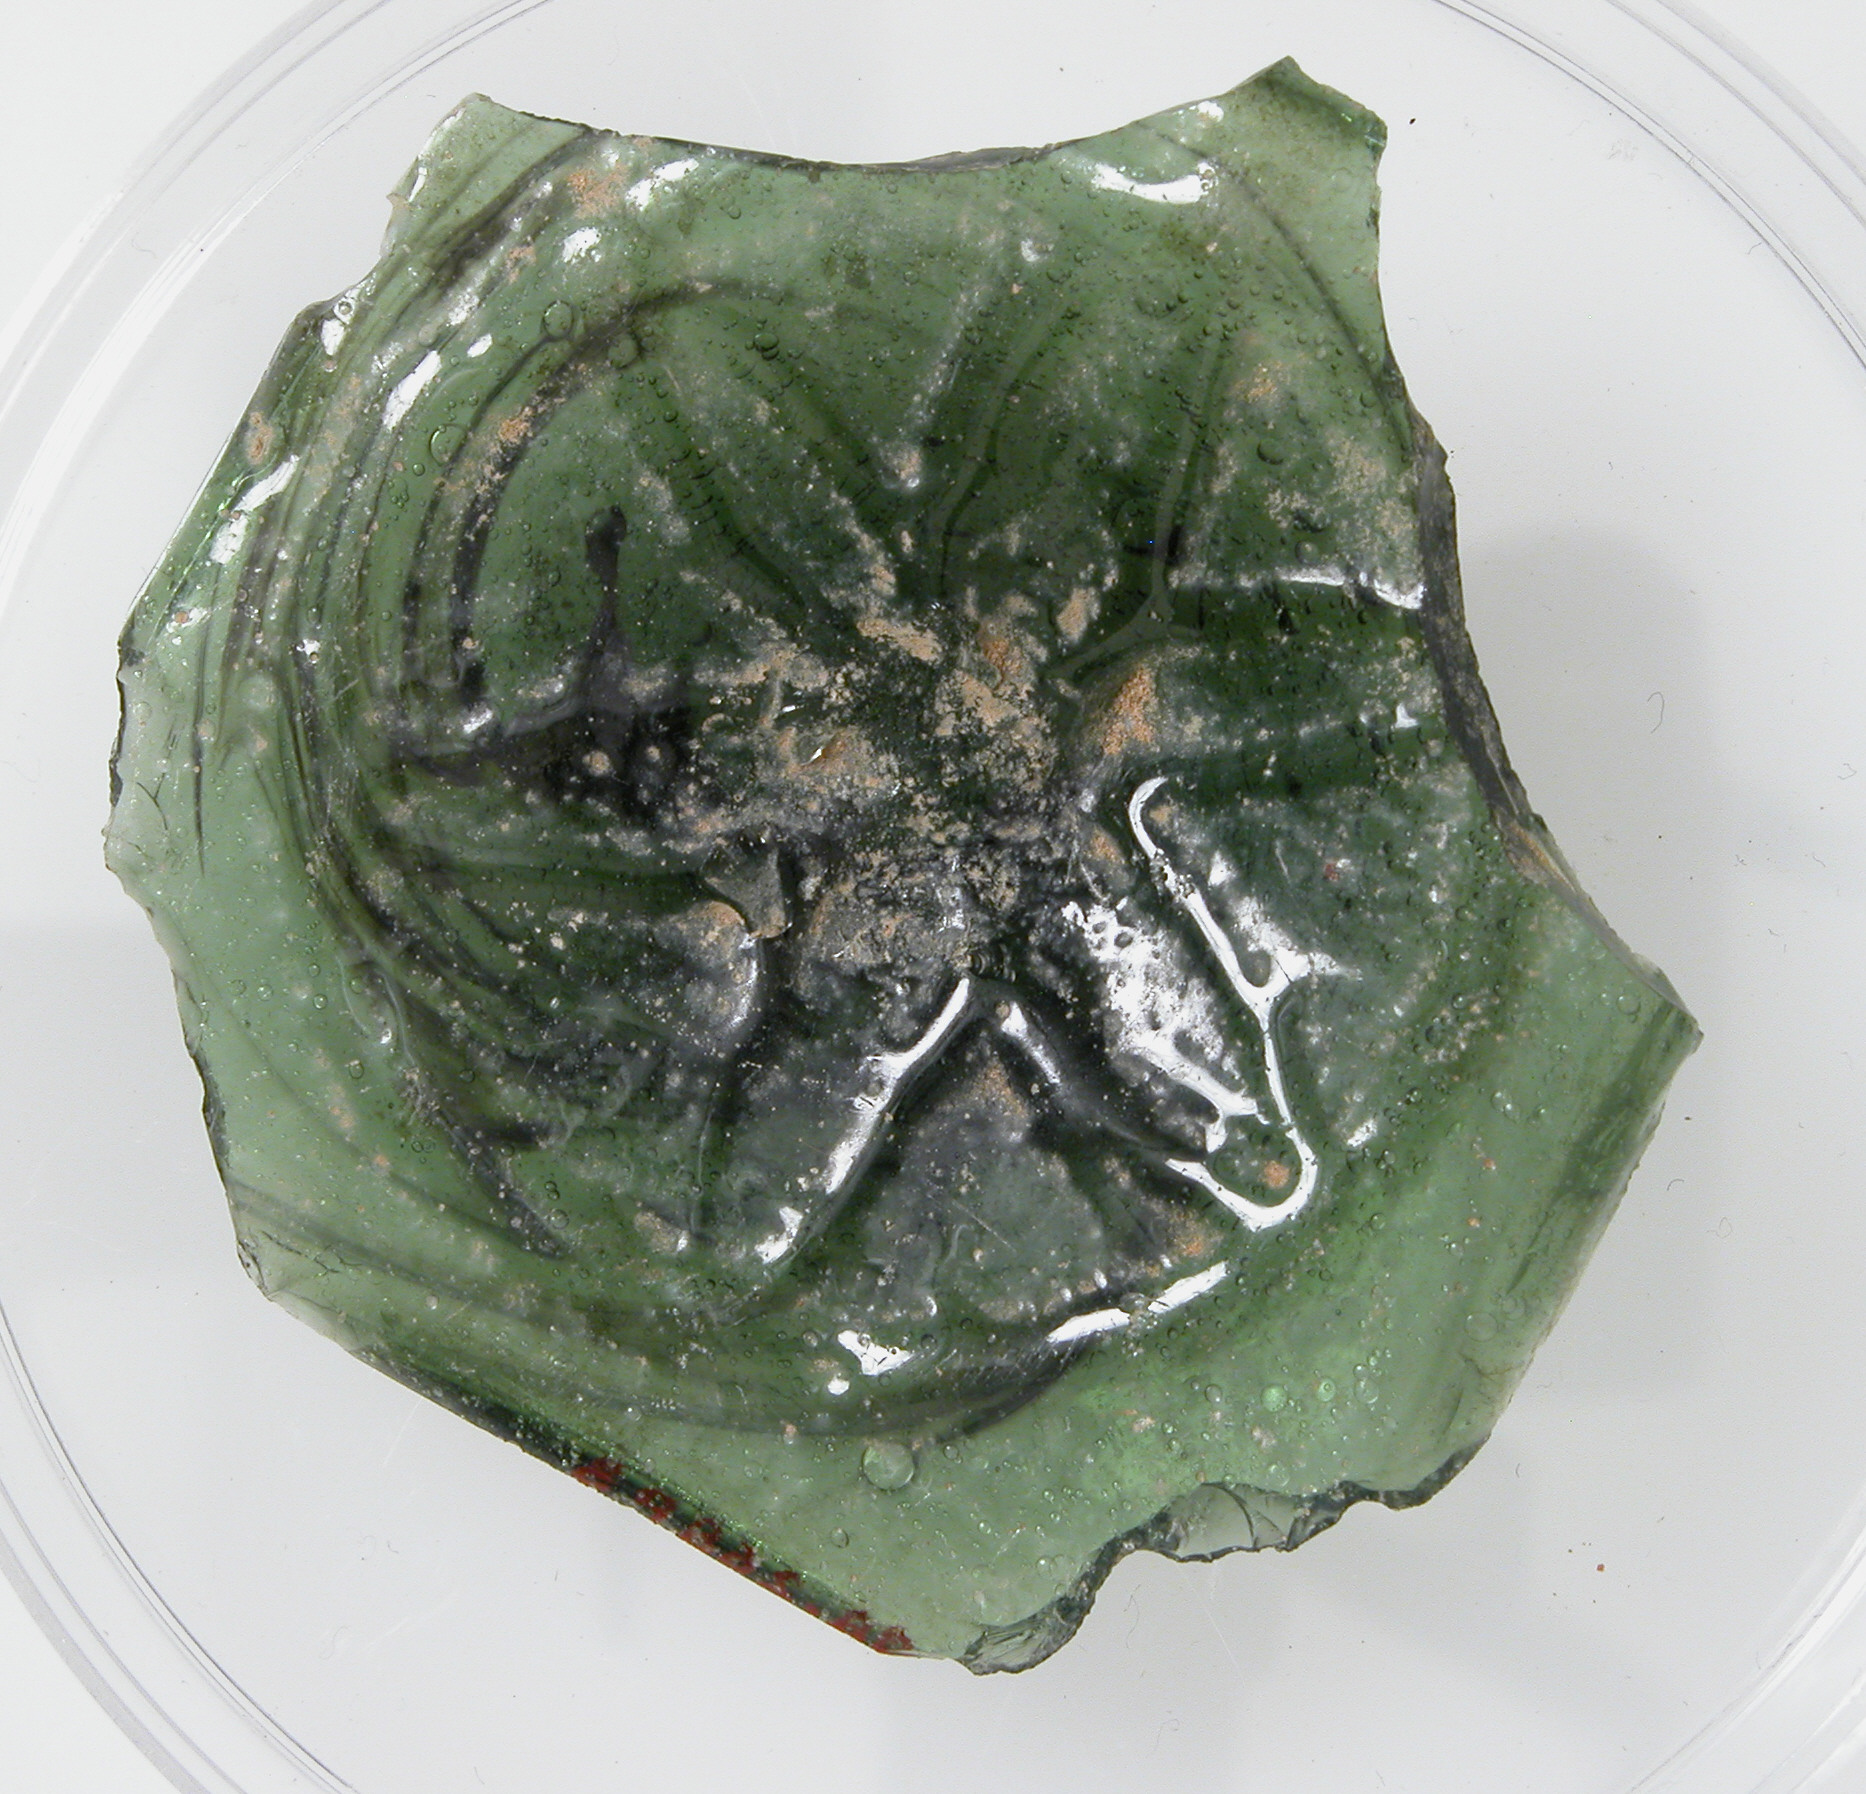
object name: fragment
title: Glass Fragment with Pressed Flower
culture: coptic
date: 301-433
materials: glass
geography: egypt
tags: flowers